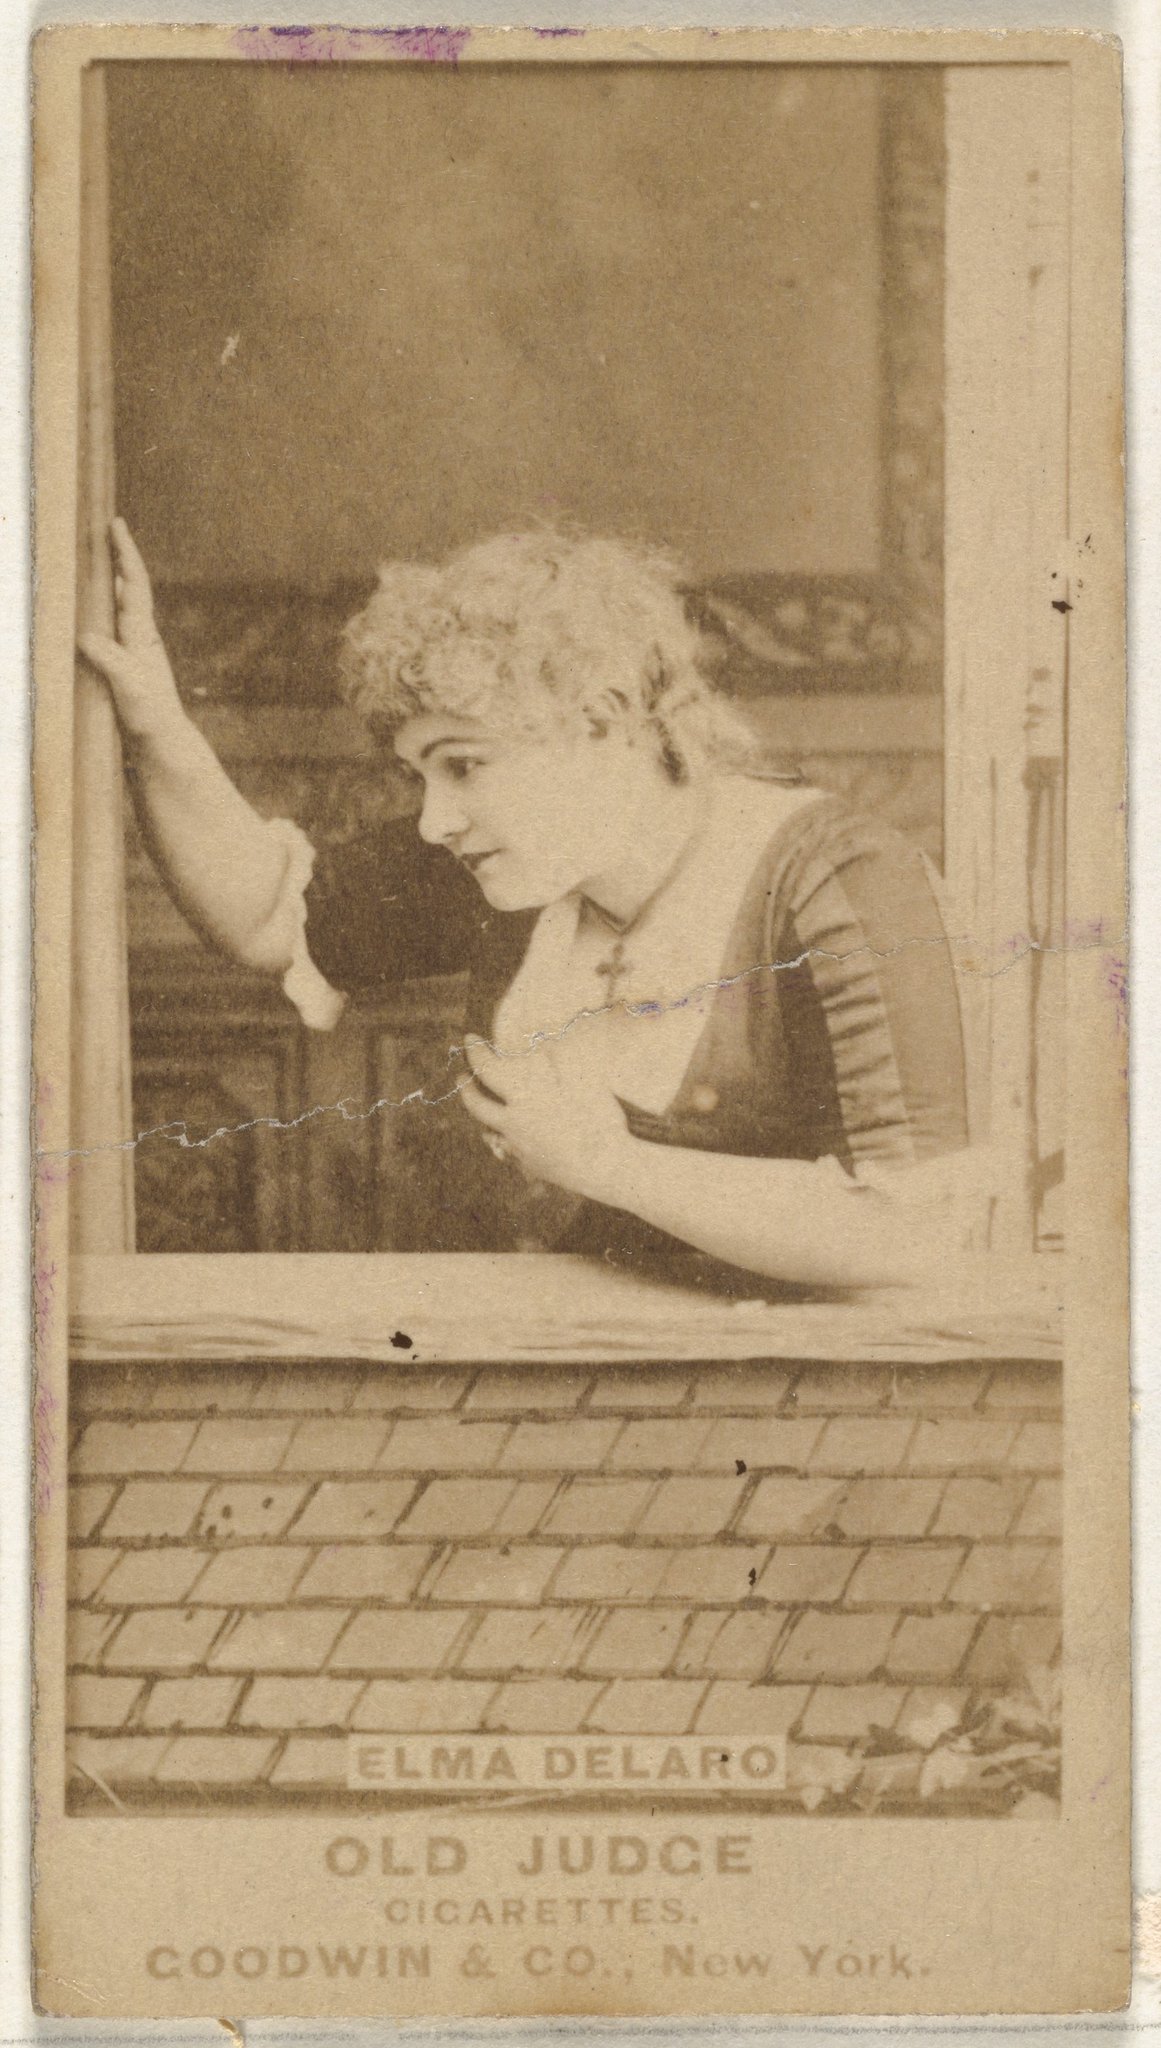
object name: photograph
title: Elma Delaro, from the Actors and Actresses series (N171) for Old Judge Cigarettes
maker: goodwin & company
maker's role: publisher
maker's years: 1850-1950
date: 1886-1890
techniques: albumen silver print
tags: portraits,women,actresses